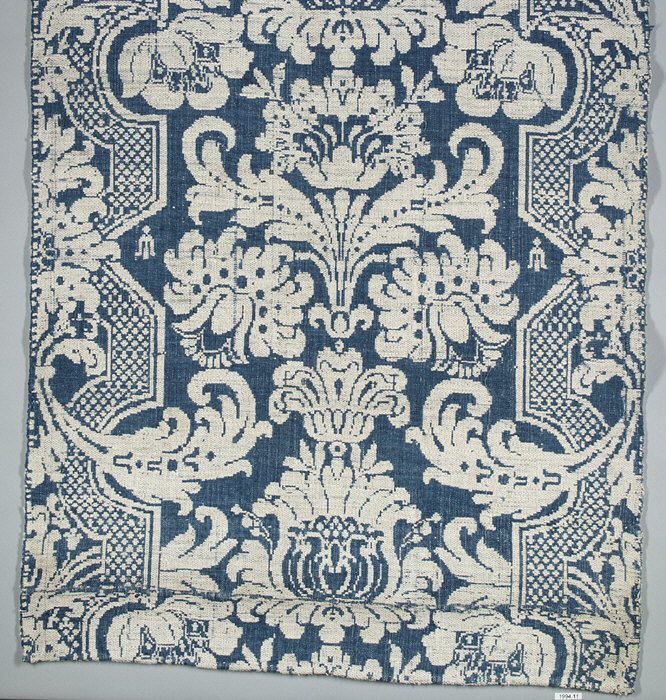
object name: length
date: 1700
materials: cotton, linen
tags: flowers